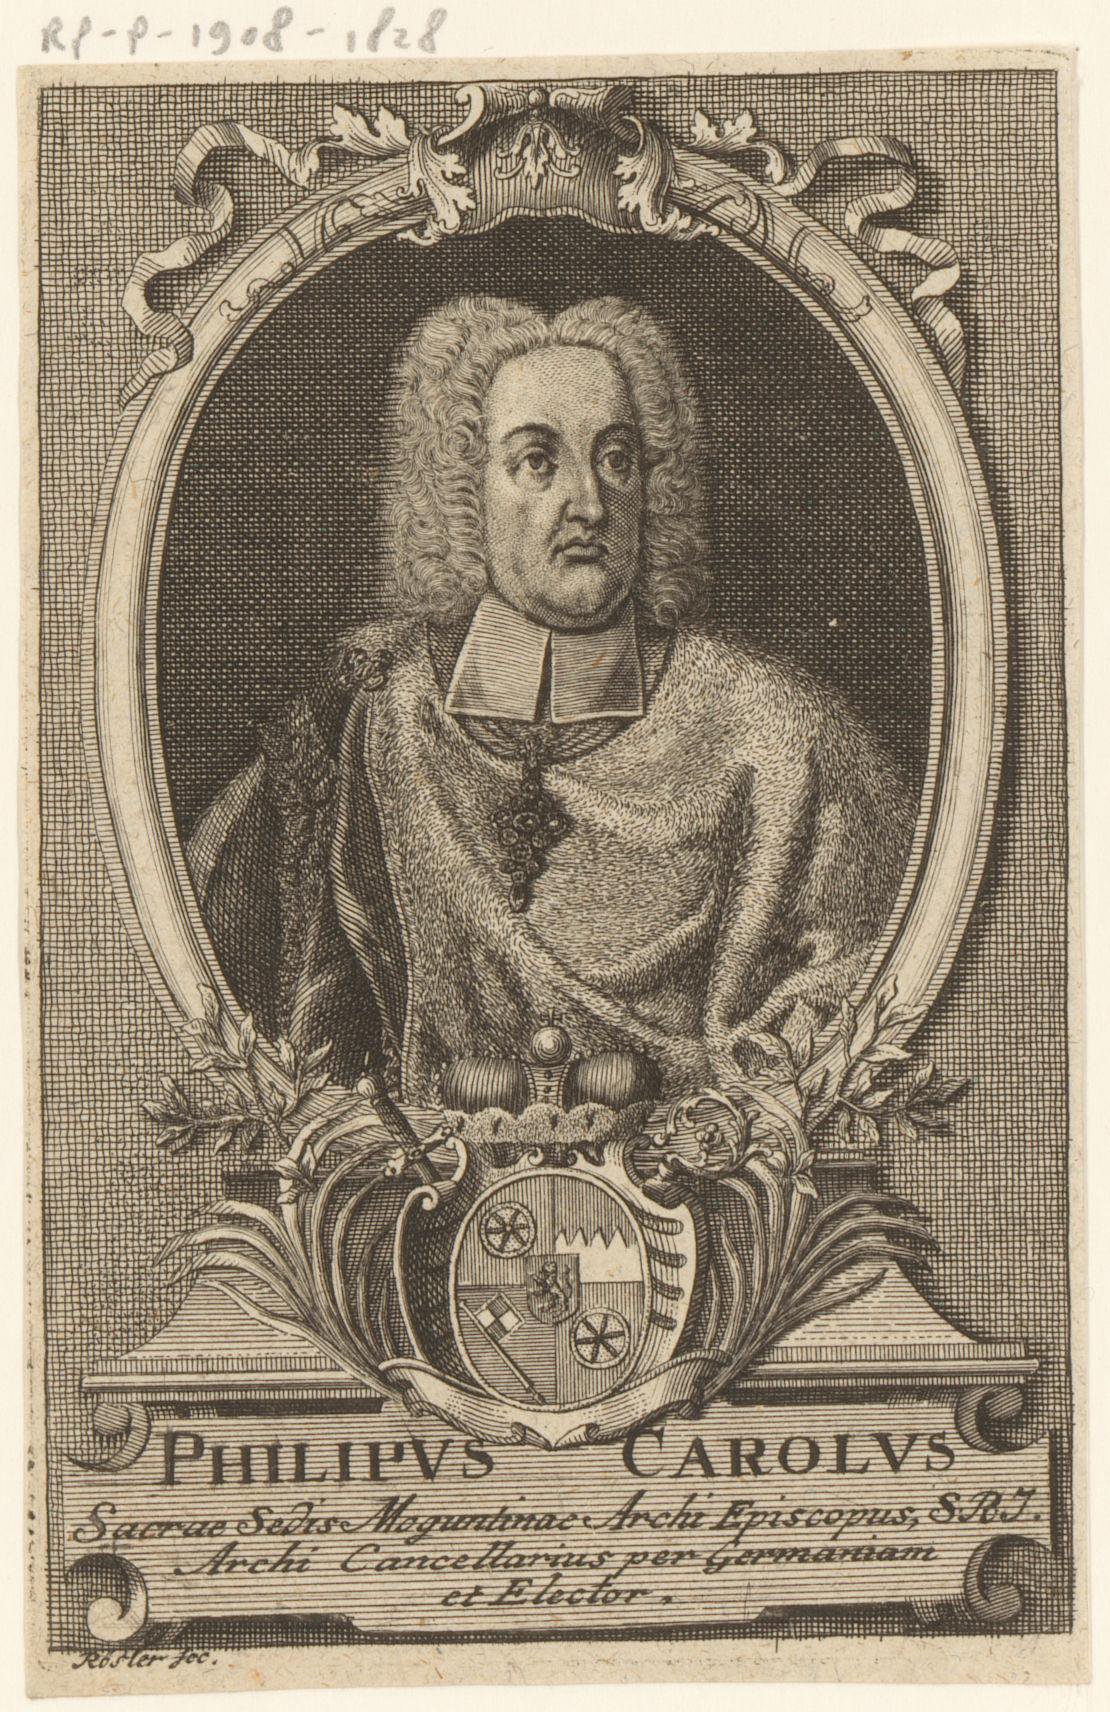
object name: print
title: Portret van Philipp Karl von Eltz-Kempenich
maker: michael rössler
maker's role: print maker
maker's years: 1705-1777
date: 1732-1777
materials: paper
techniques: engraving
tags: theologian, historical persons, armorial bearing, heraldry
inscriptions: collector's mark: Lugt 2228